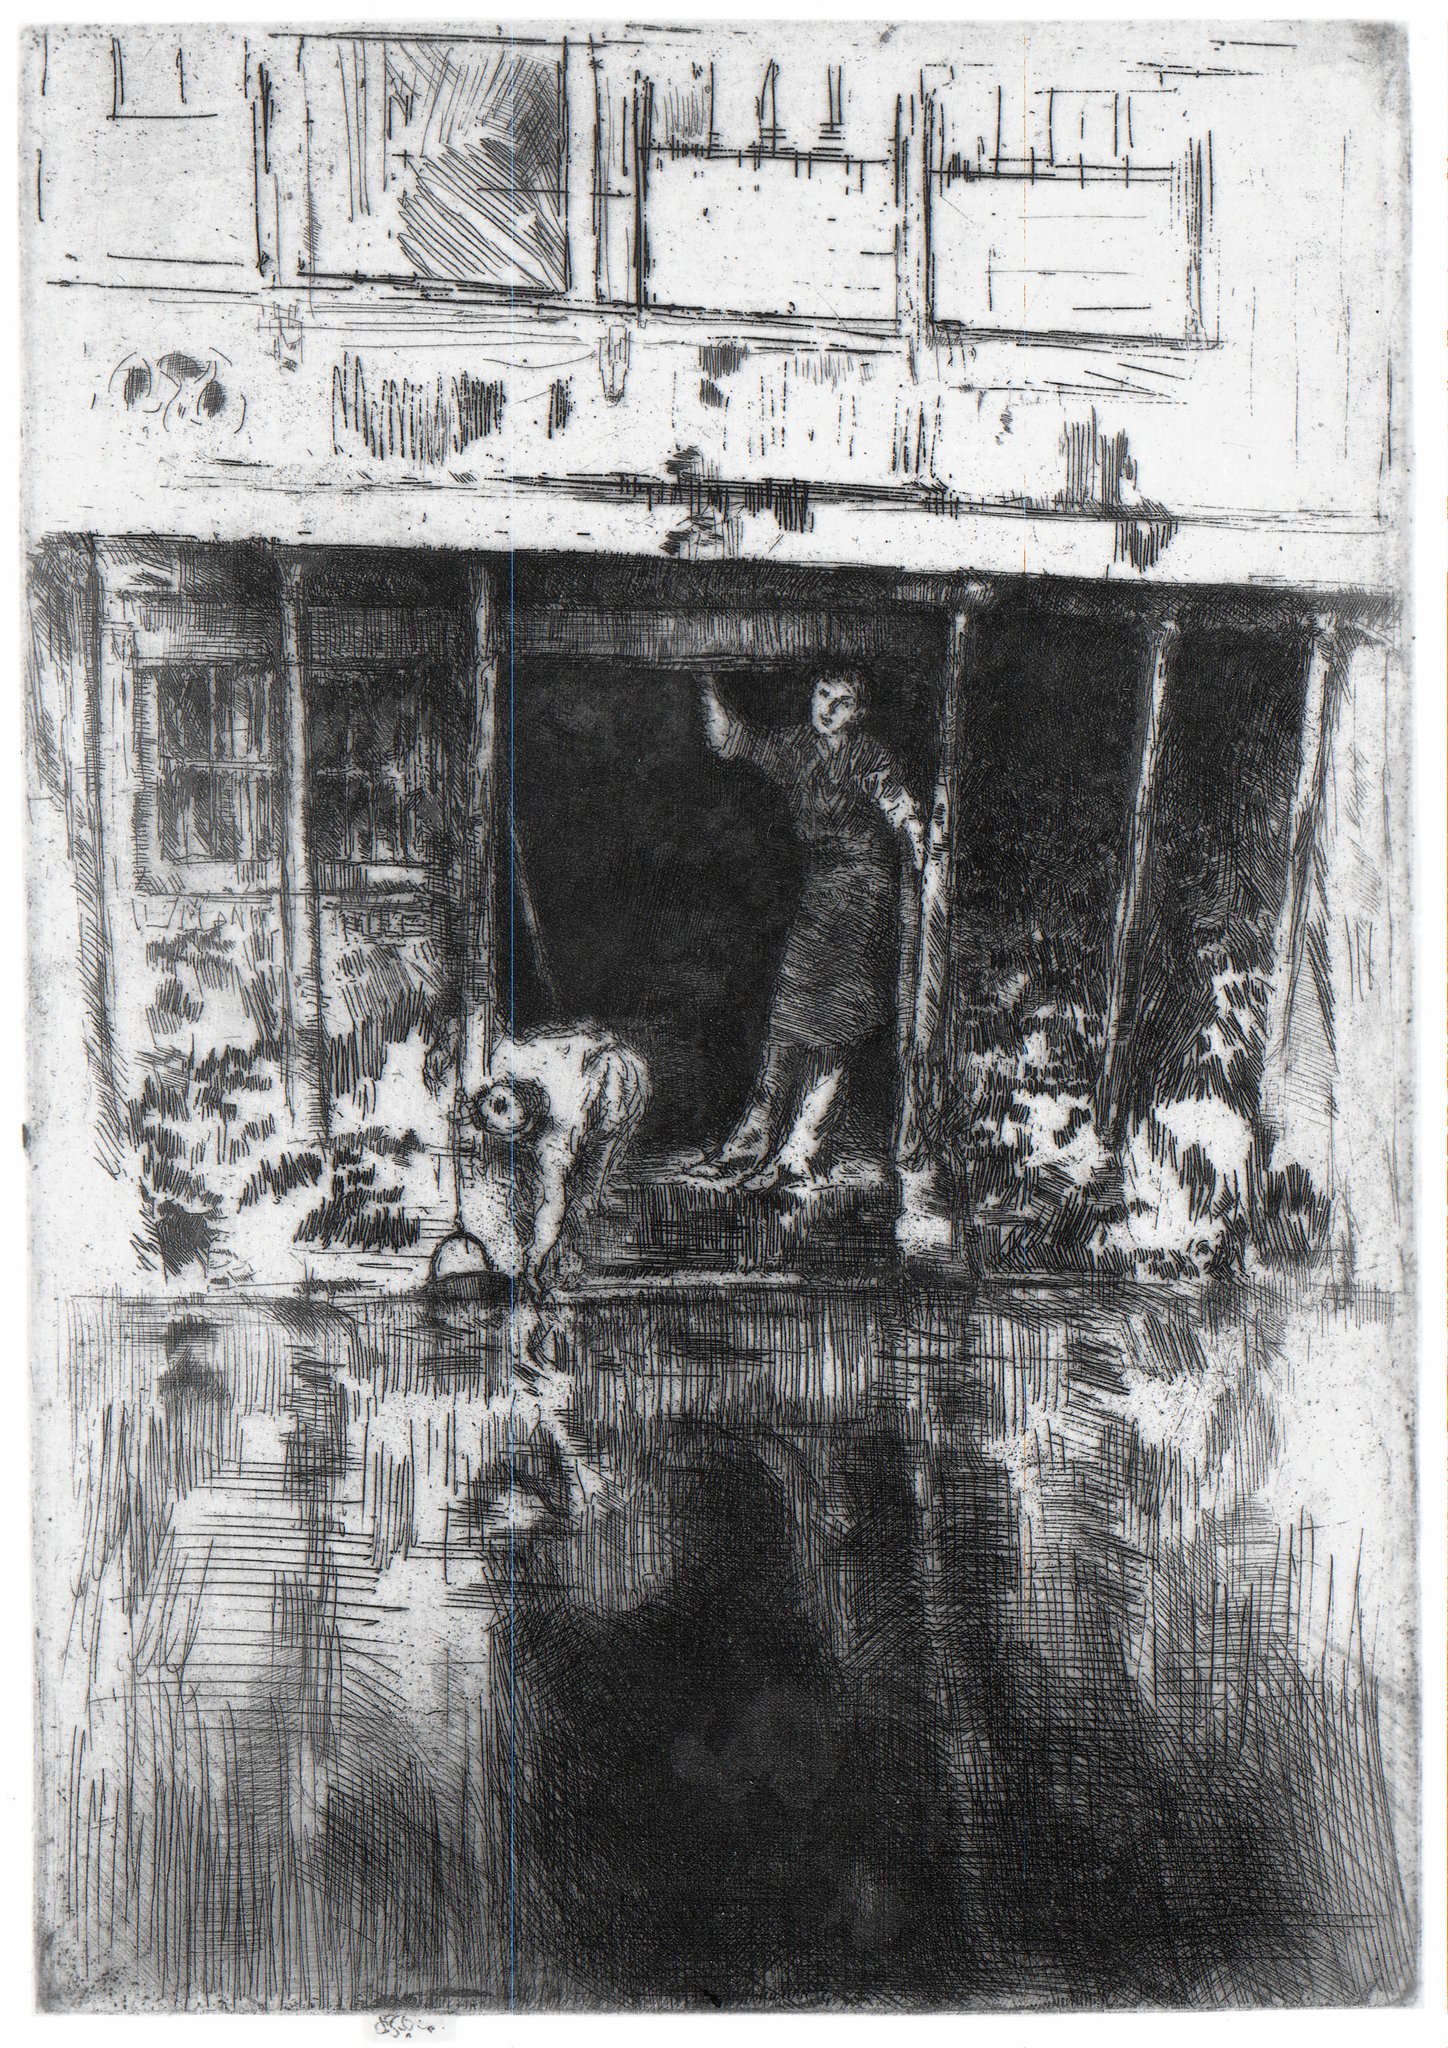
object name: print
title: Pierrot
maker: james abbott mcneill whistler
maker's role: painter, print maker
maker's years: 1834-1903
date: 1889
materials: paper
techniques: drypoint, etching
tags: urban housing, canals, waters (in city), amsterdam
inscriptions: signature: ‘JW imp’, collector's mark: Lugt 2760, collector's mark: Lugt 2228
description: Twee mannen in de deuropening van een huis aan de gracht in Amsterdam, waarschijnlijk op de Oudezijds Achterburgwal. Één schept met een emmer water uit de gracht.